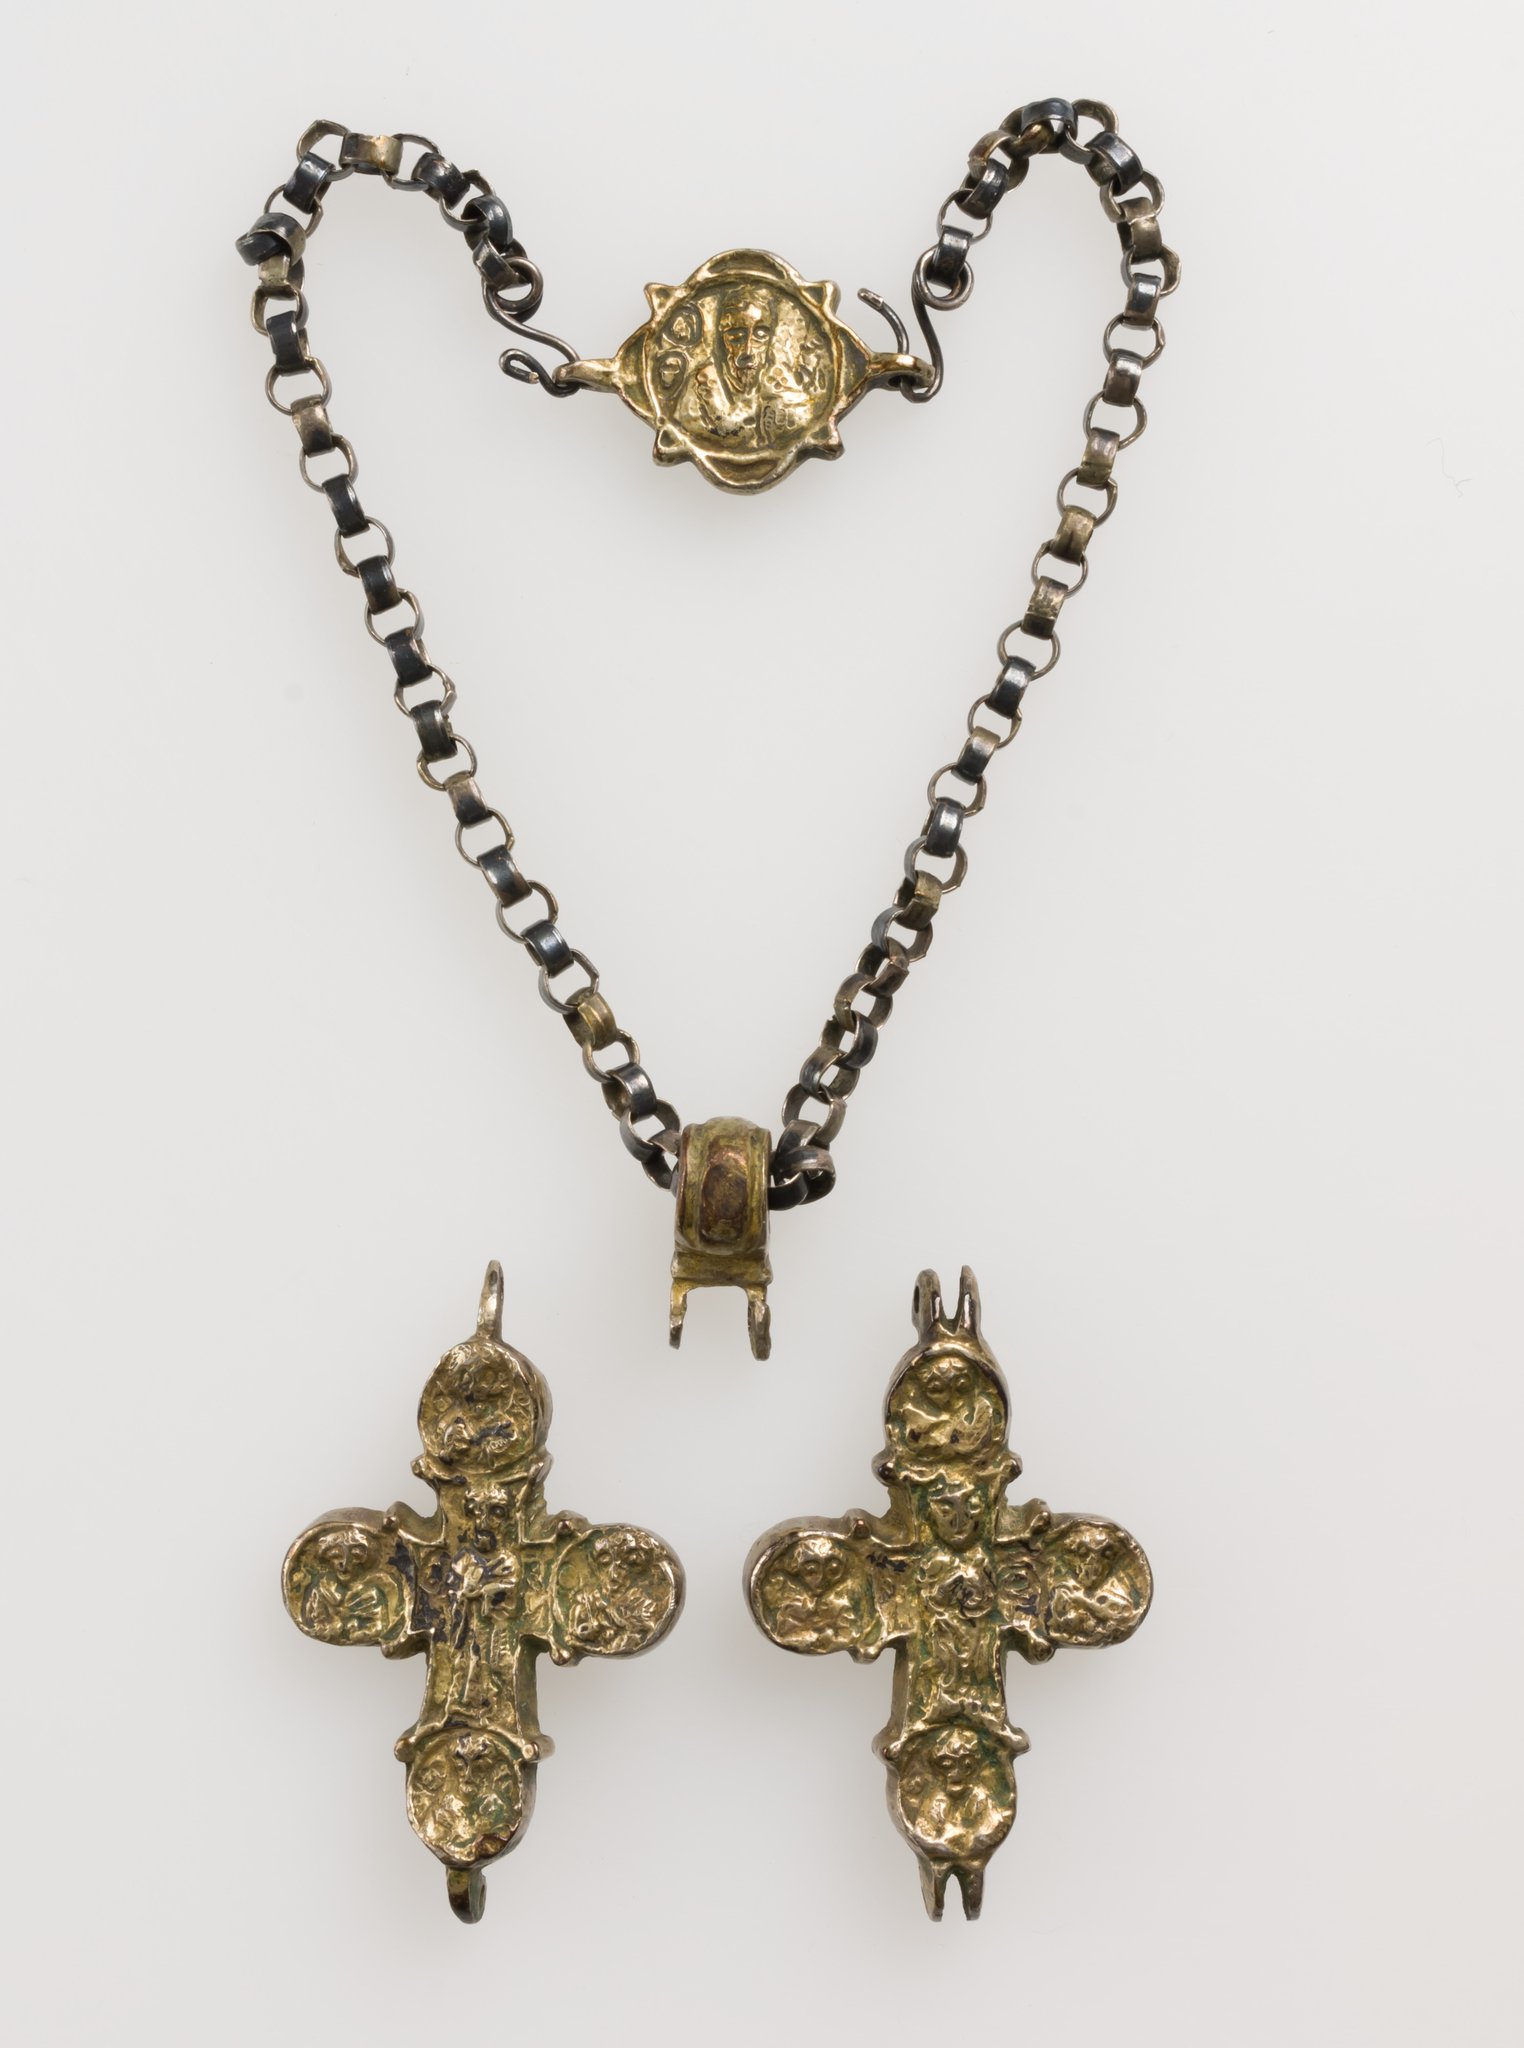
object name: reliquary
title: Pendant Cross Reliquary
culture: byzantine or russian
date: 1101-1400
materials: gilt silver, silver